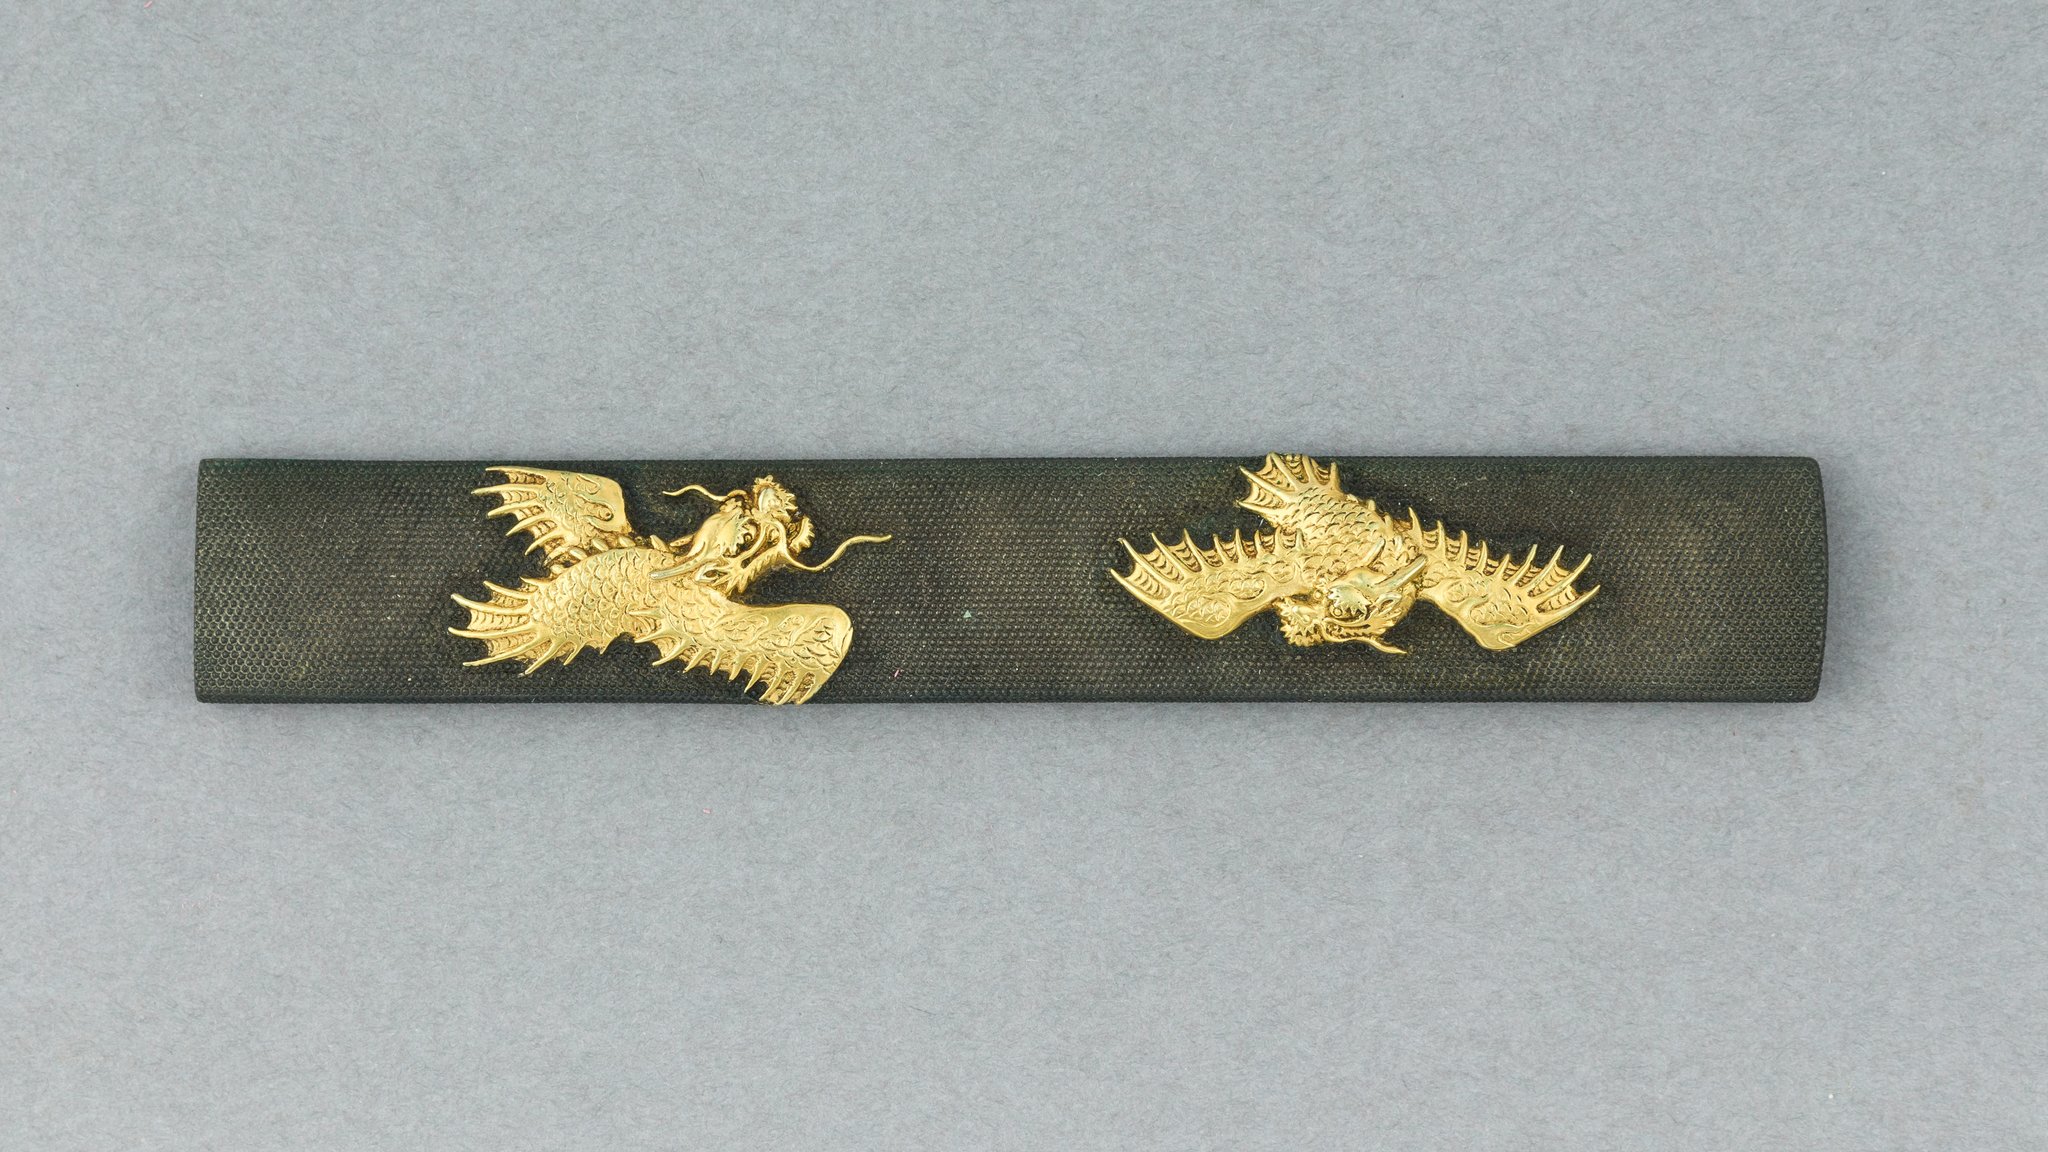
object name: knife handle kozuka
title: Knife Handle (Kozuka)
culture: japanese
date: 1615-1868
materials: silver alloy, gold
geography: japan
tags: mythical creatures